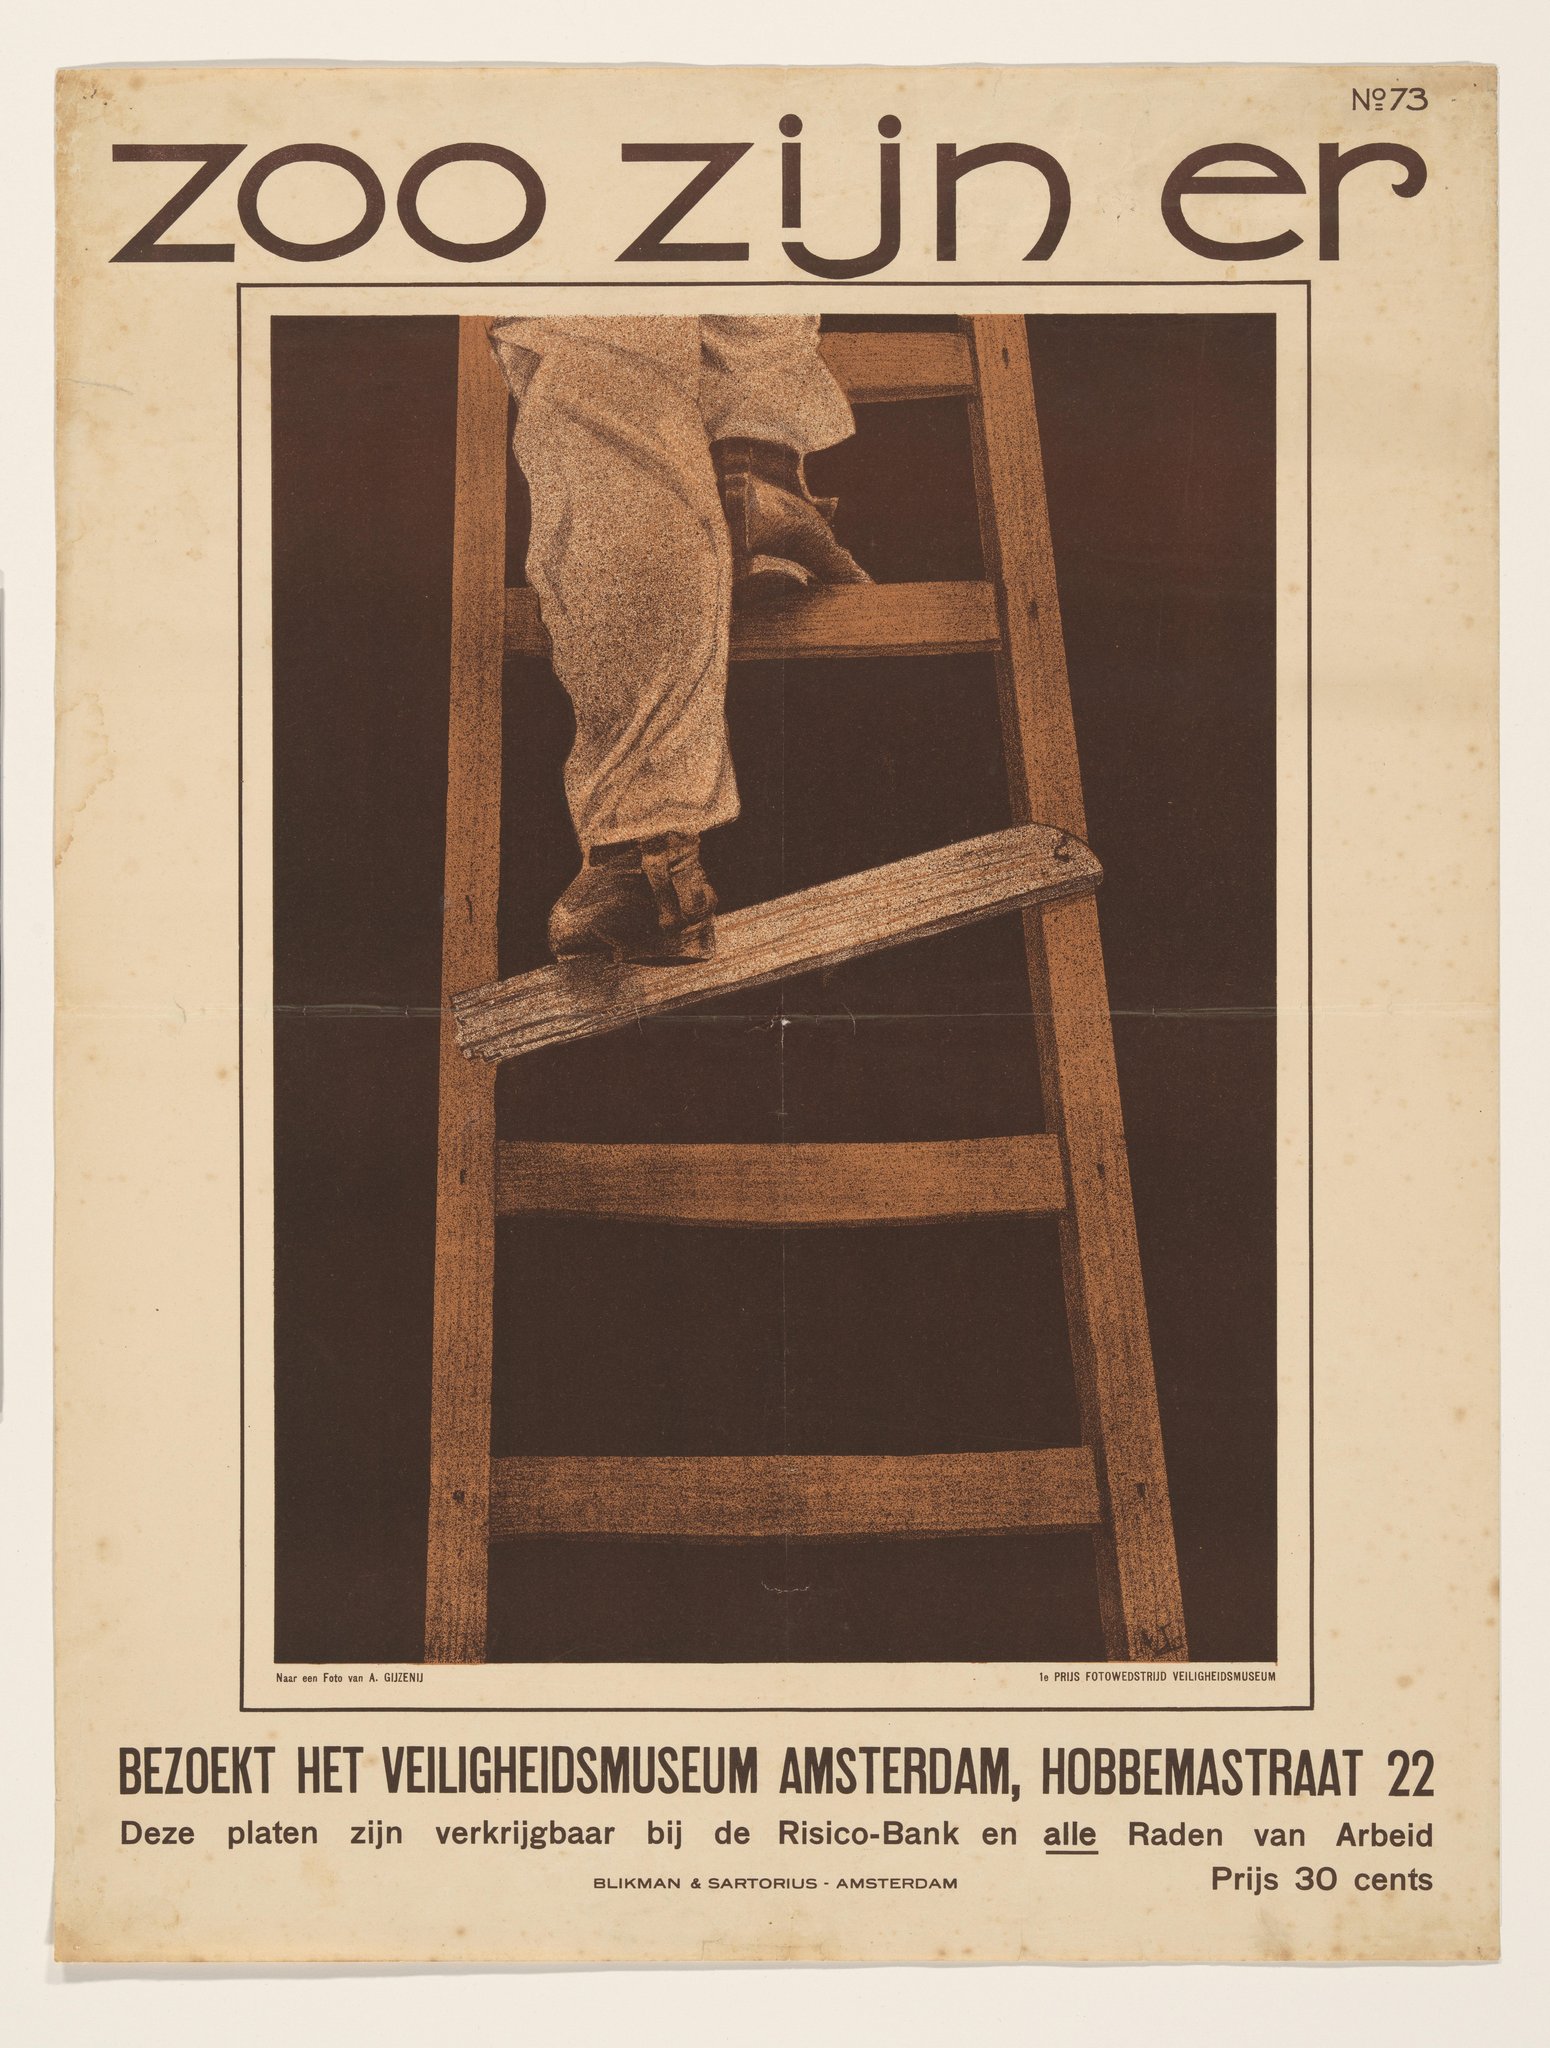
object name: poster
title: Zoo Zijn er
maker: Anonymous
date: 1920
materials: paper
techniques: lithograph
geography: netherlands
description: Poster uitgegeven door het Veiligheids Instituut/Veiligheids Museum.